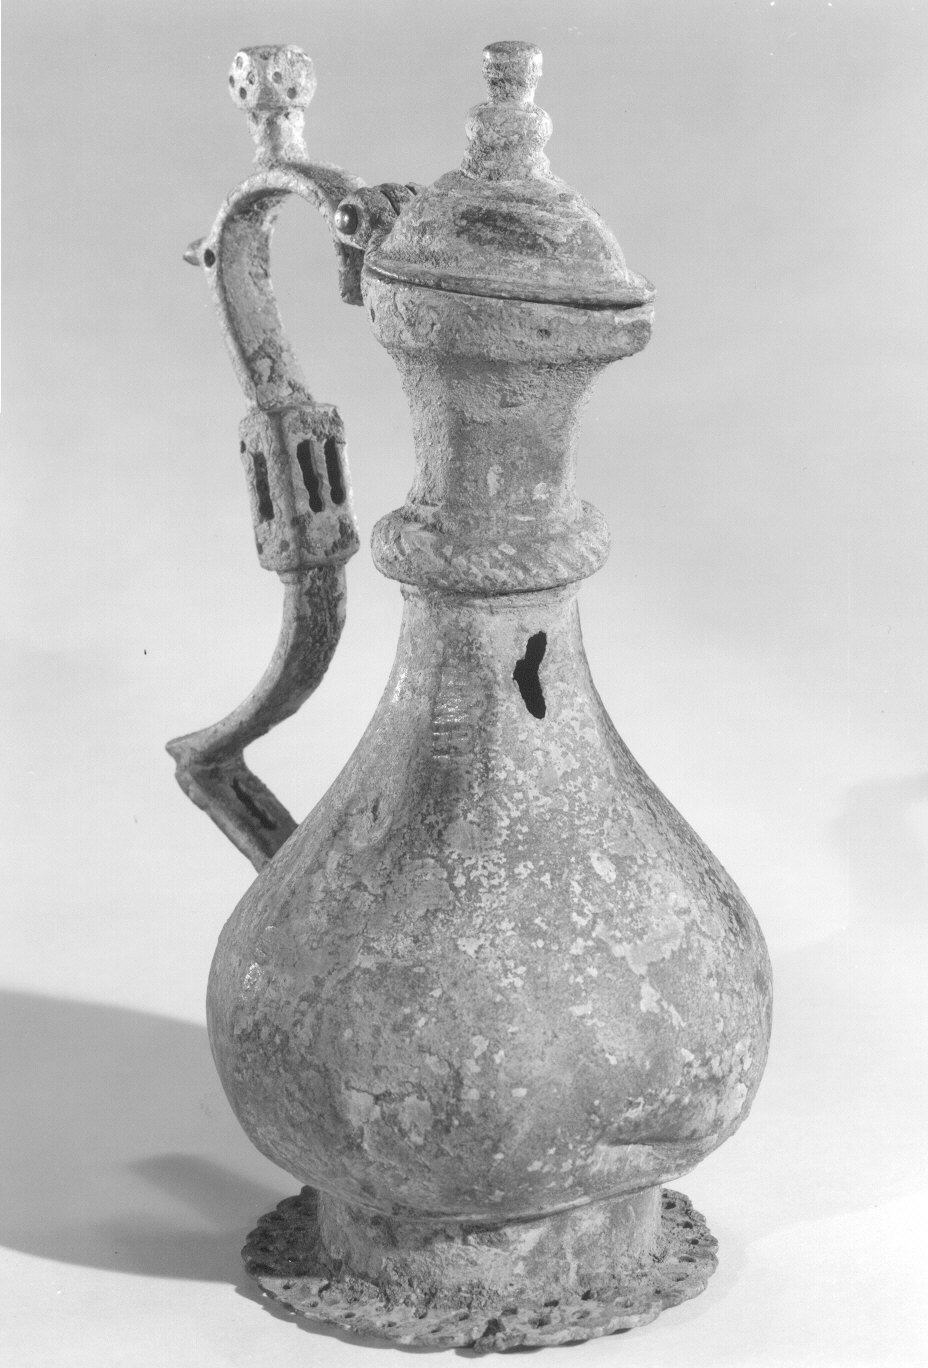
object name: ewer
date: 701-900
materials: bronze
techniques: casting, engraving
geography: iran